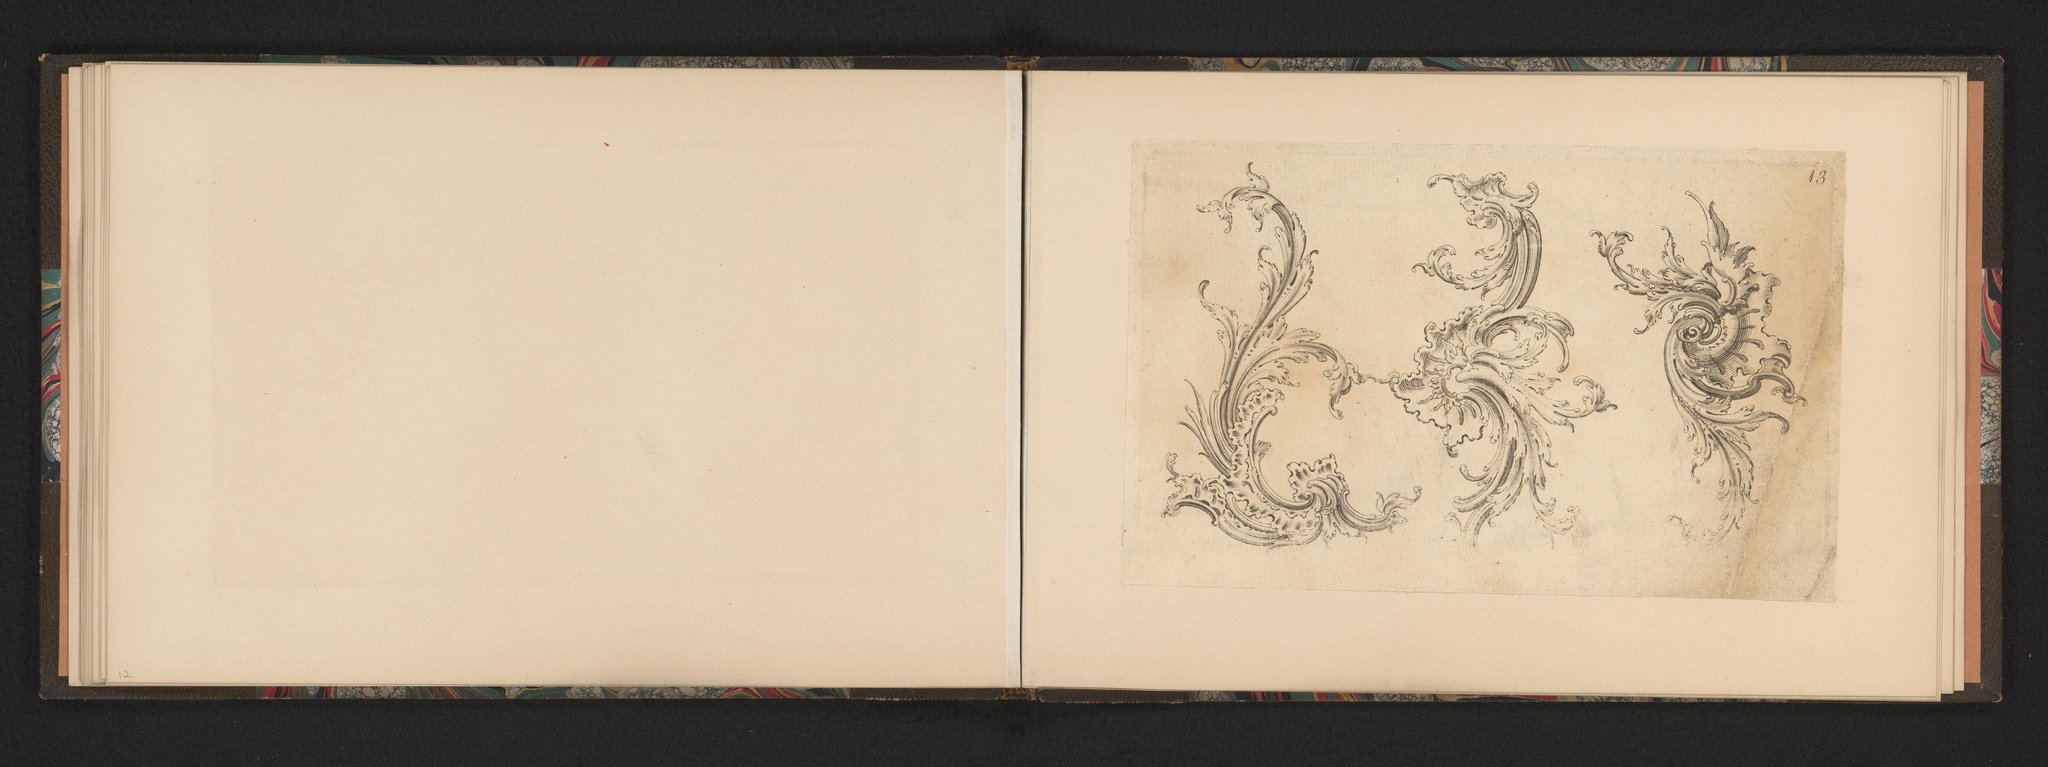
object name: album leaf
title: Ornamentele versiering van krulornamenten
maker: p. baretti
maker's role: print maker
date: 1766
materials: paper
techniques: engraving, etching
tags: ornaments ~ art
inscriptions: number: ‘13’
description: Ingeplakte prent met ornamentele versiering van krulornamenten. Prent maakt deel uit van een album.